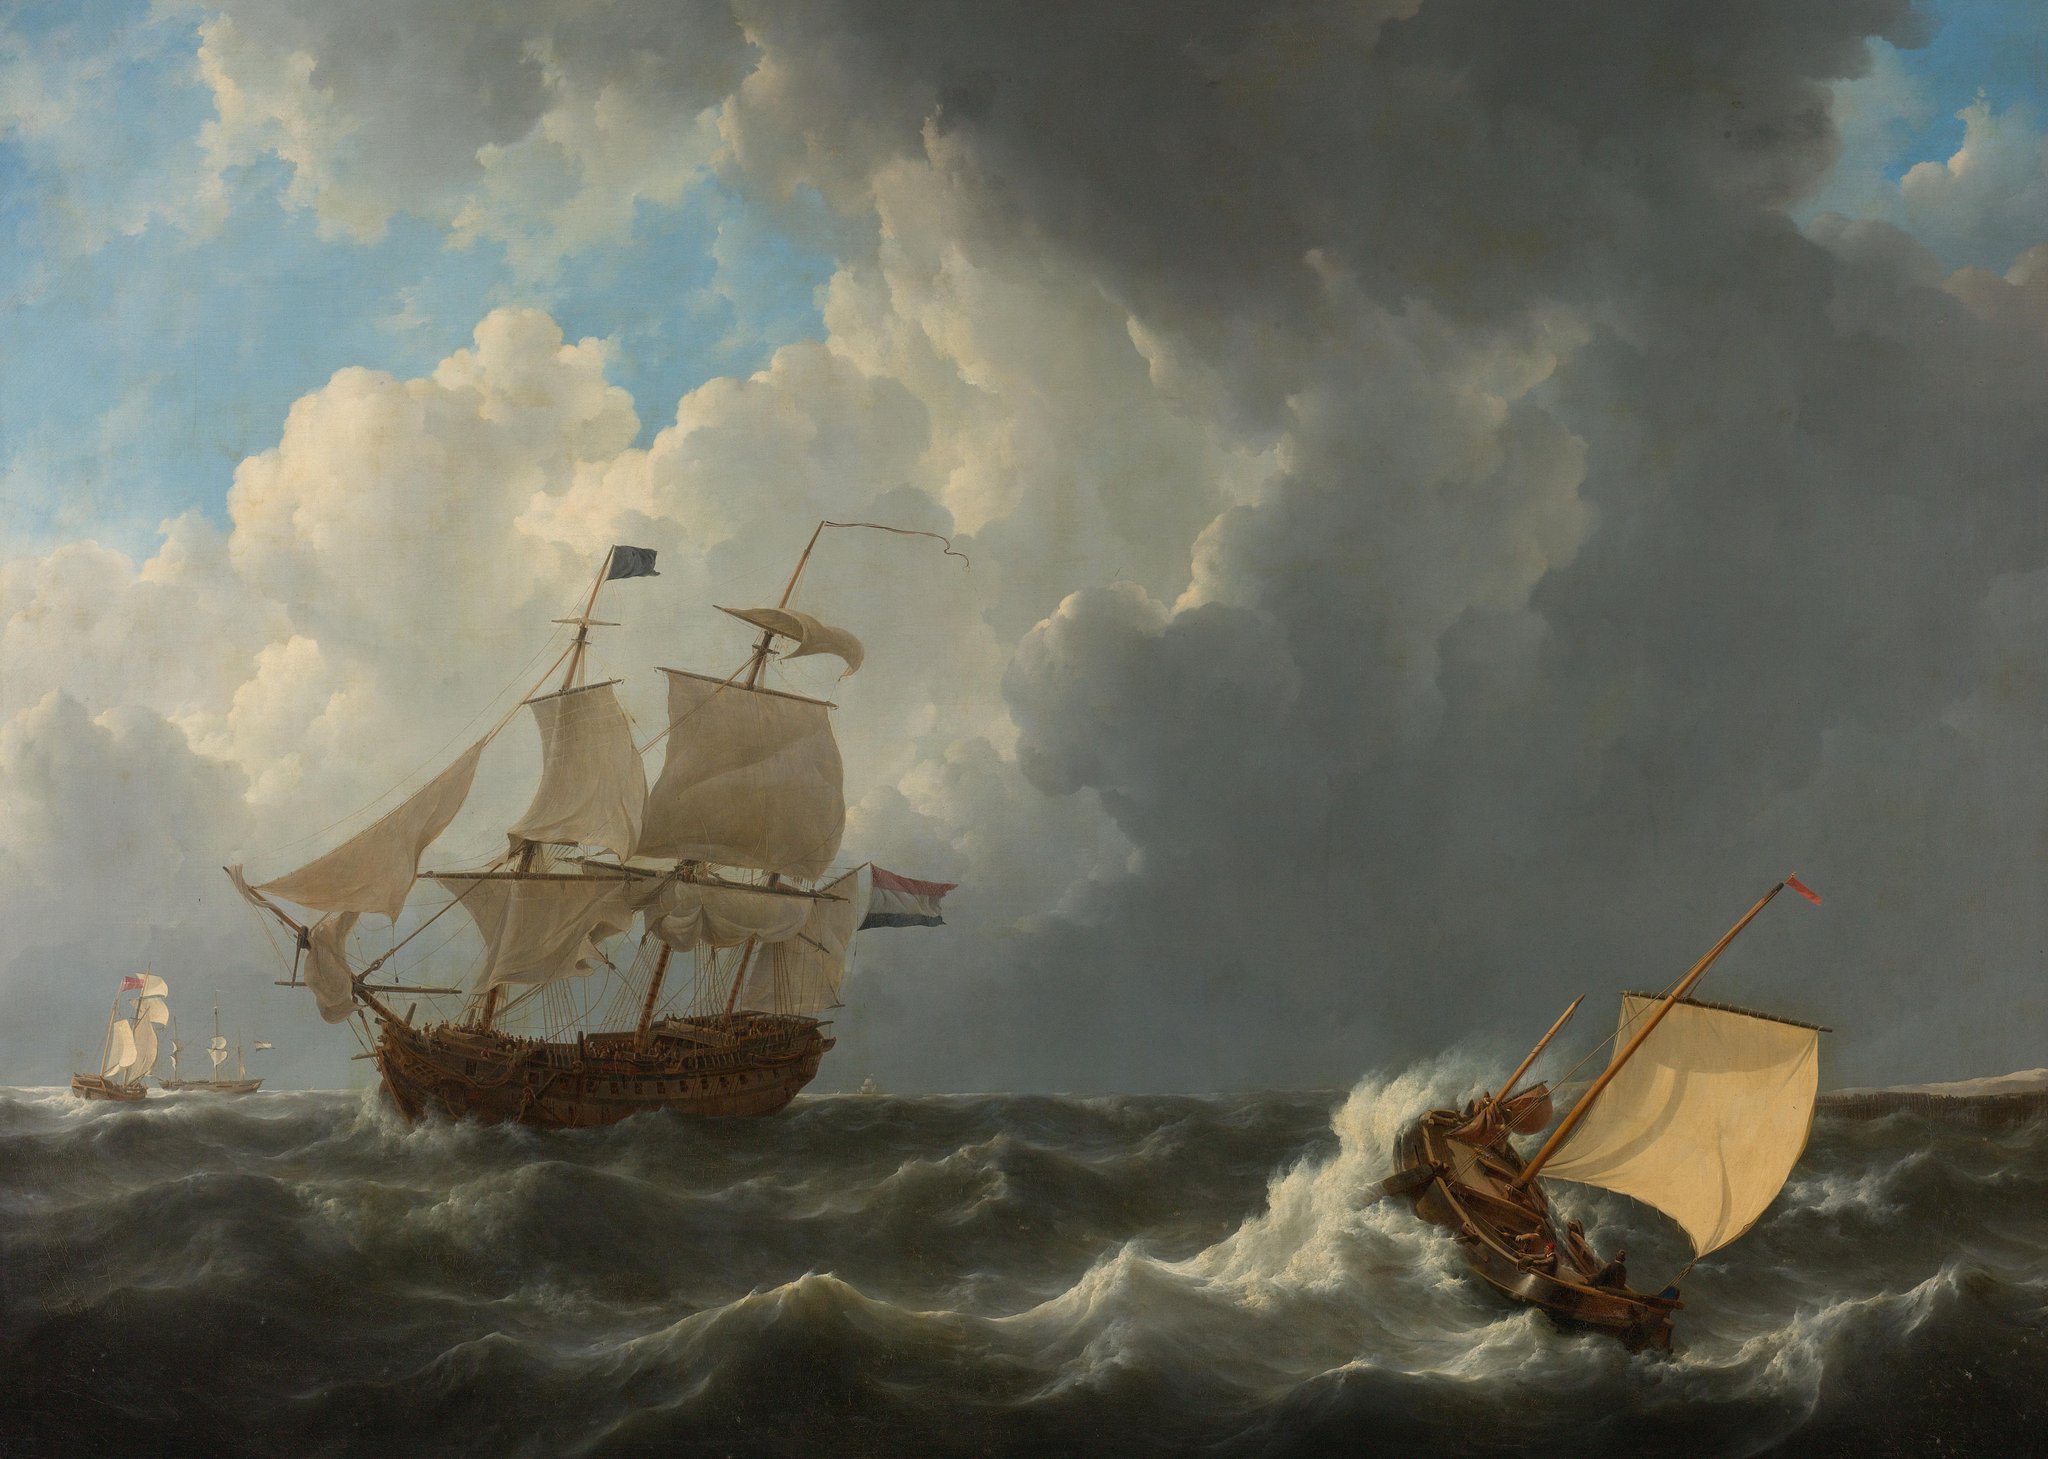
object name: painting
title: Ships in a Turbulent Sea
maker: johannes christiaan schotel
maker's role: draughtsman, painter, print maker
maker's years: 1787-1838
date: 1826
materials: canvas, oil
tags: sailing-ship, sailing-boat, sea (seascape), storm at sea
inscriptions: signature: ‘J.C. Schotel F.’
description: Schepen op een onstuimige zee. Links een oorlogsschip, op de voorgrond een Blankenbergse schuit.